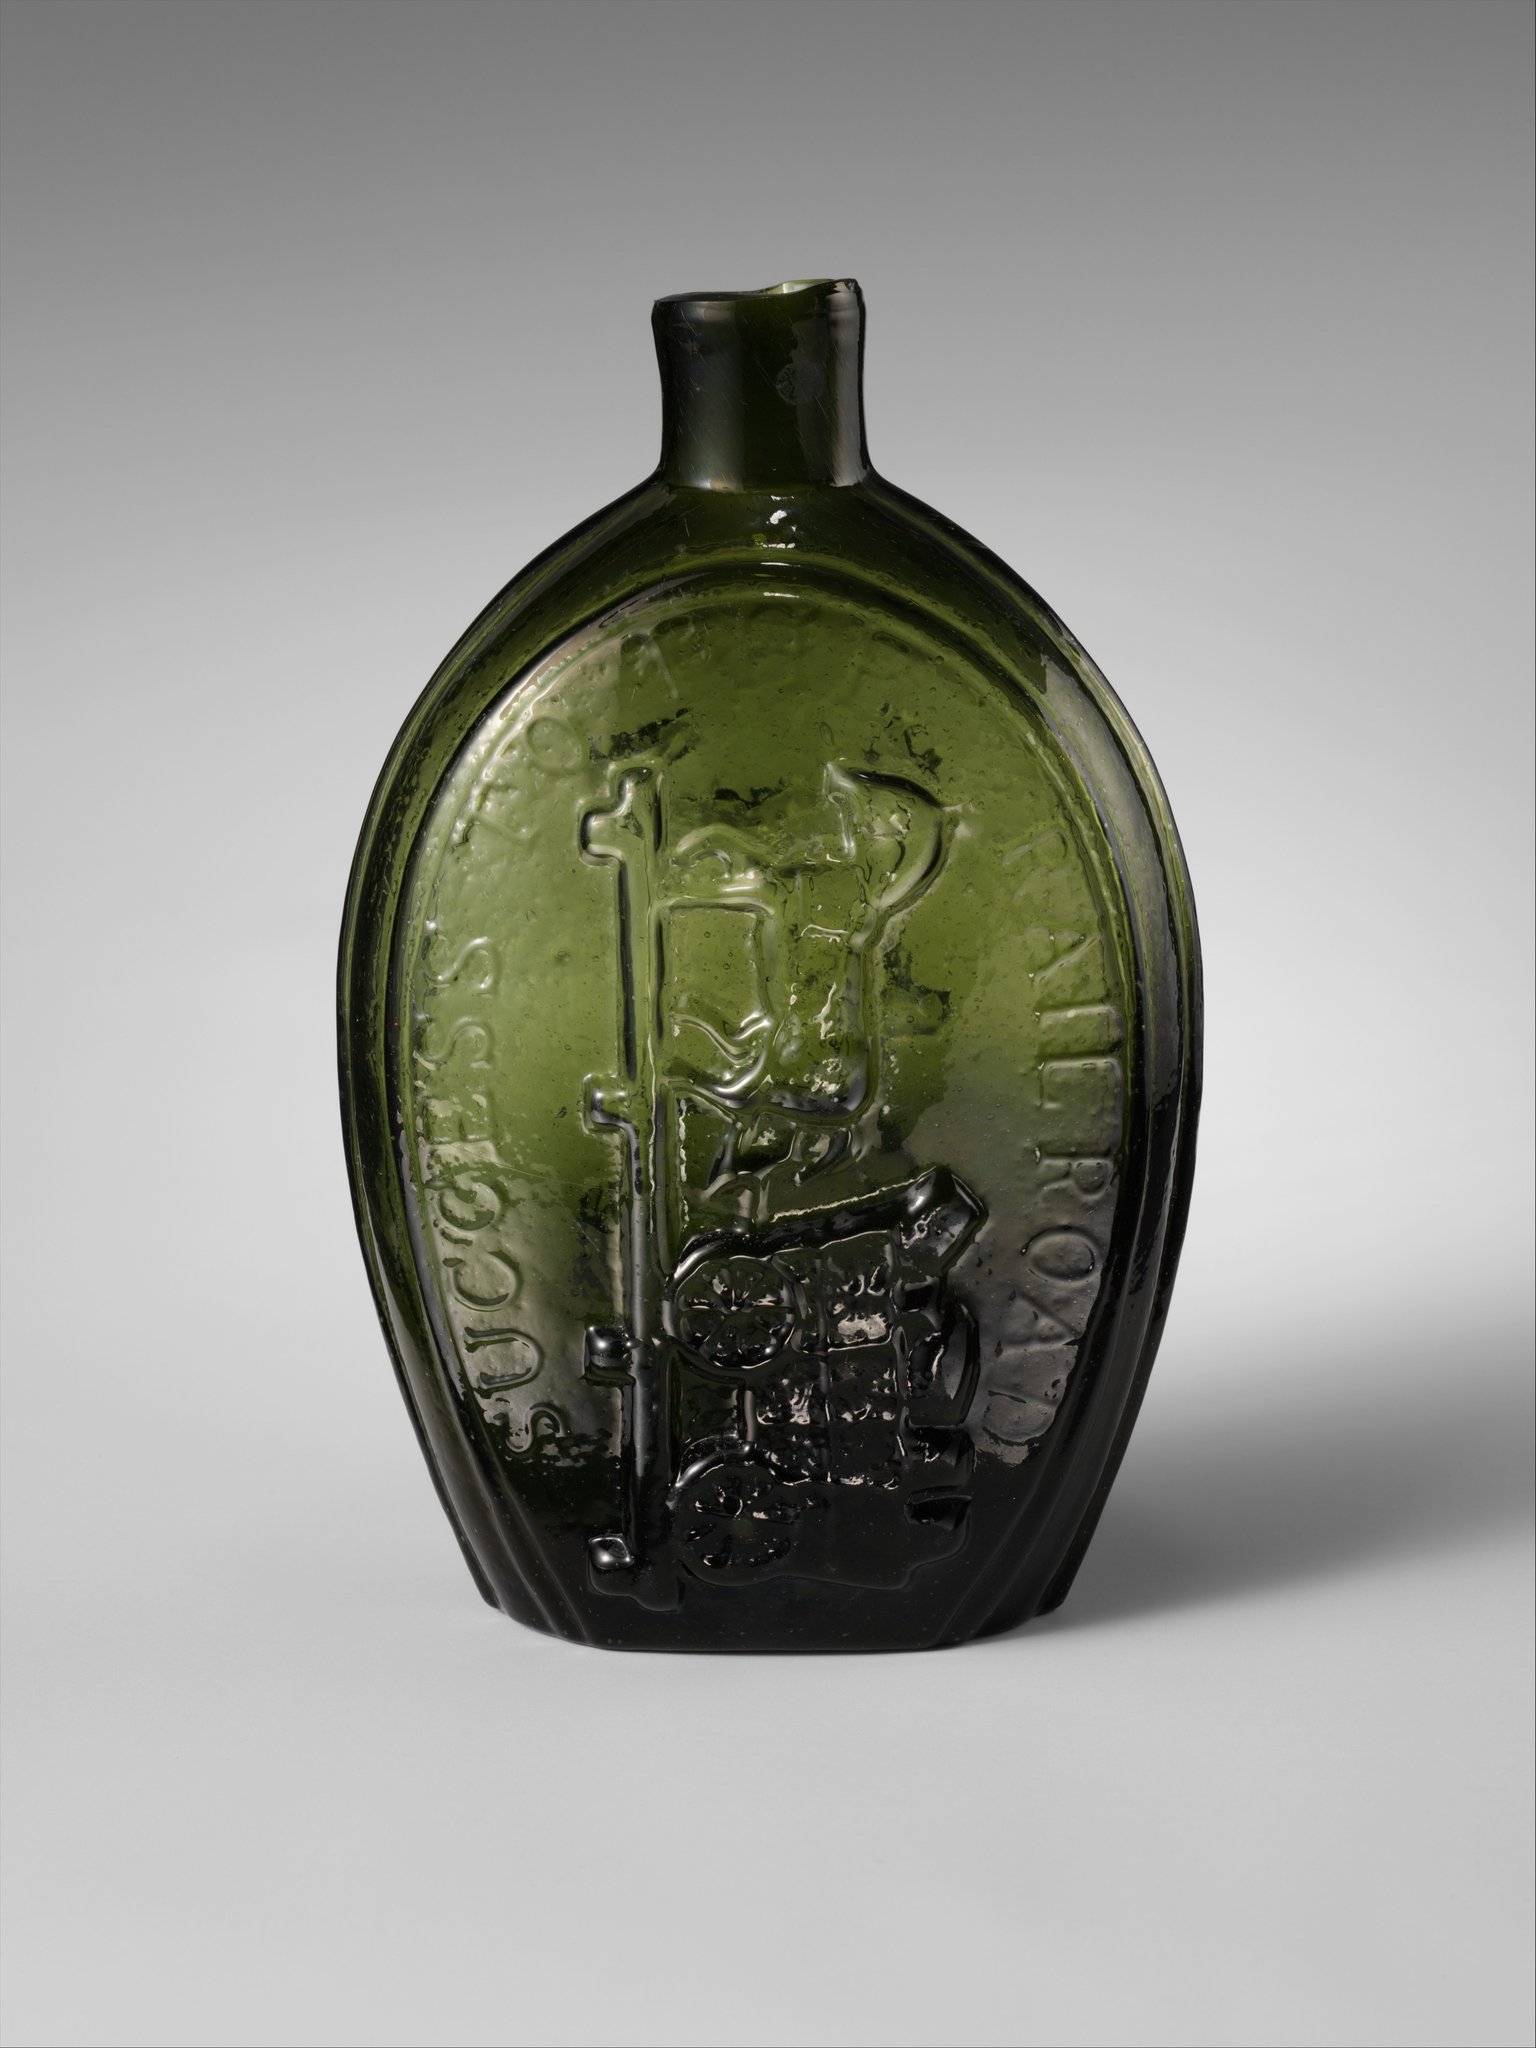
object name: flask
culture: american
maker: mount vernon glass works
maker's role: maker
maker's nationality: american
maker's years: 1810-1844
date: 1835-1840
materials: glass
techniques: glassblowing, molding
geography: united states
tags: horses,carts